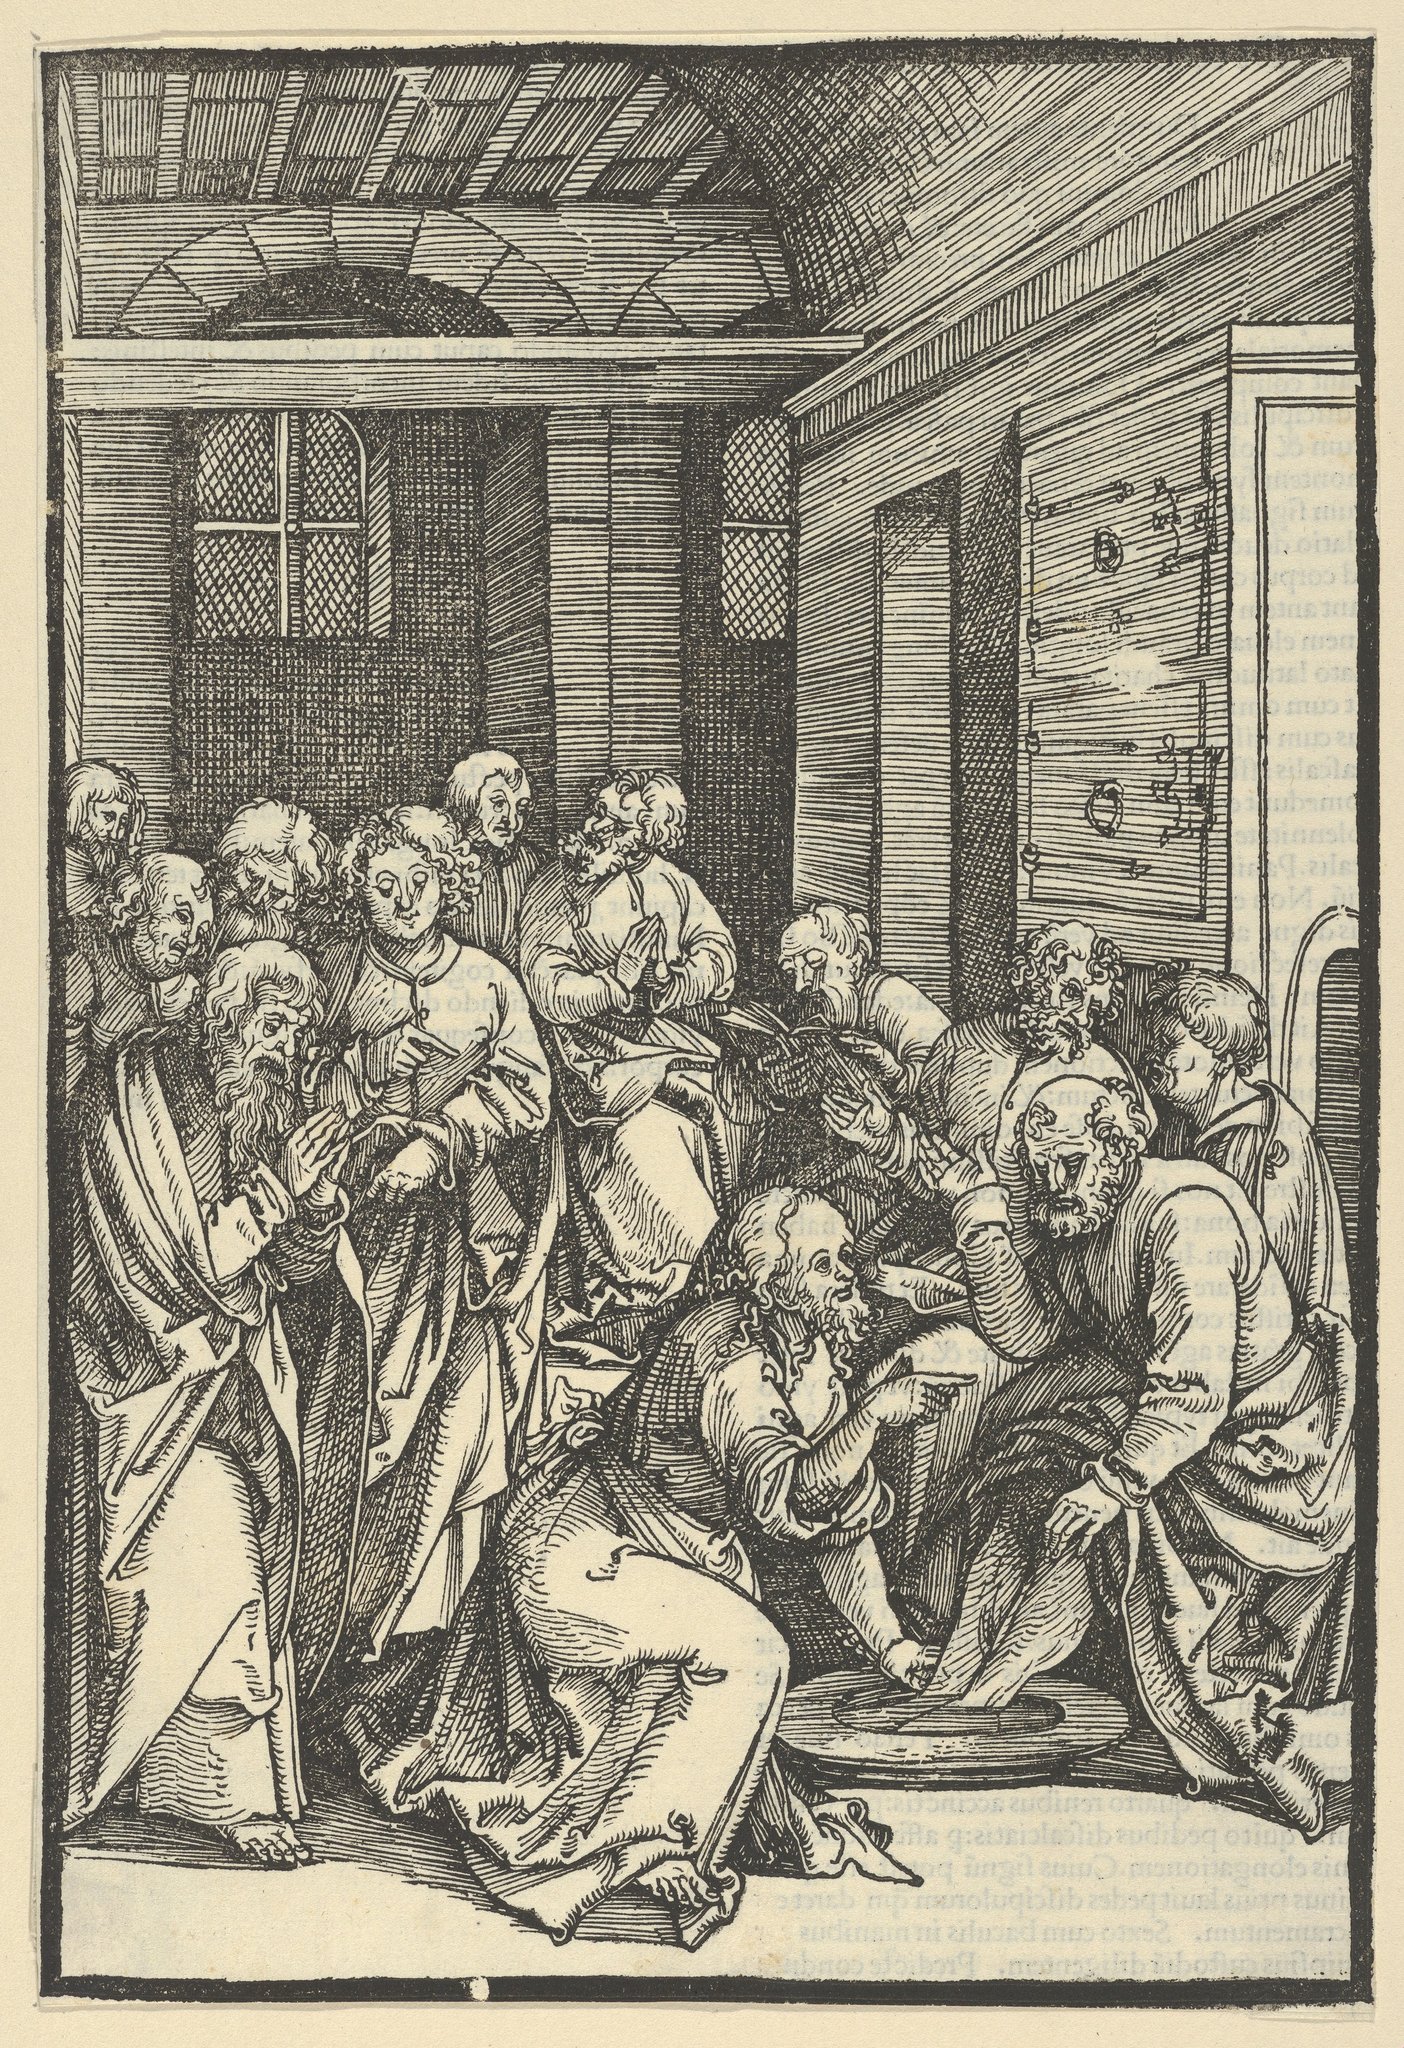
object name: print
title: Christ Washing Saint Peter's Feet, from Speculum passionis domini nostri Ihesu Christi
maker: hans schäufelein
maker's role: artist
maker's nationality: german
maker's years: 1480-1540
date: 1507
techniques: woodcut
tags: men,women,christ,saint peter